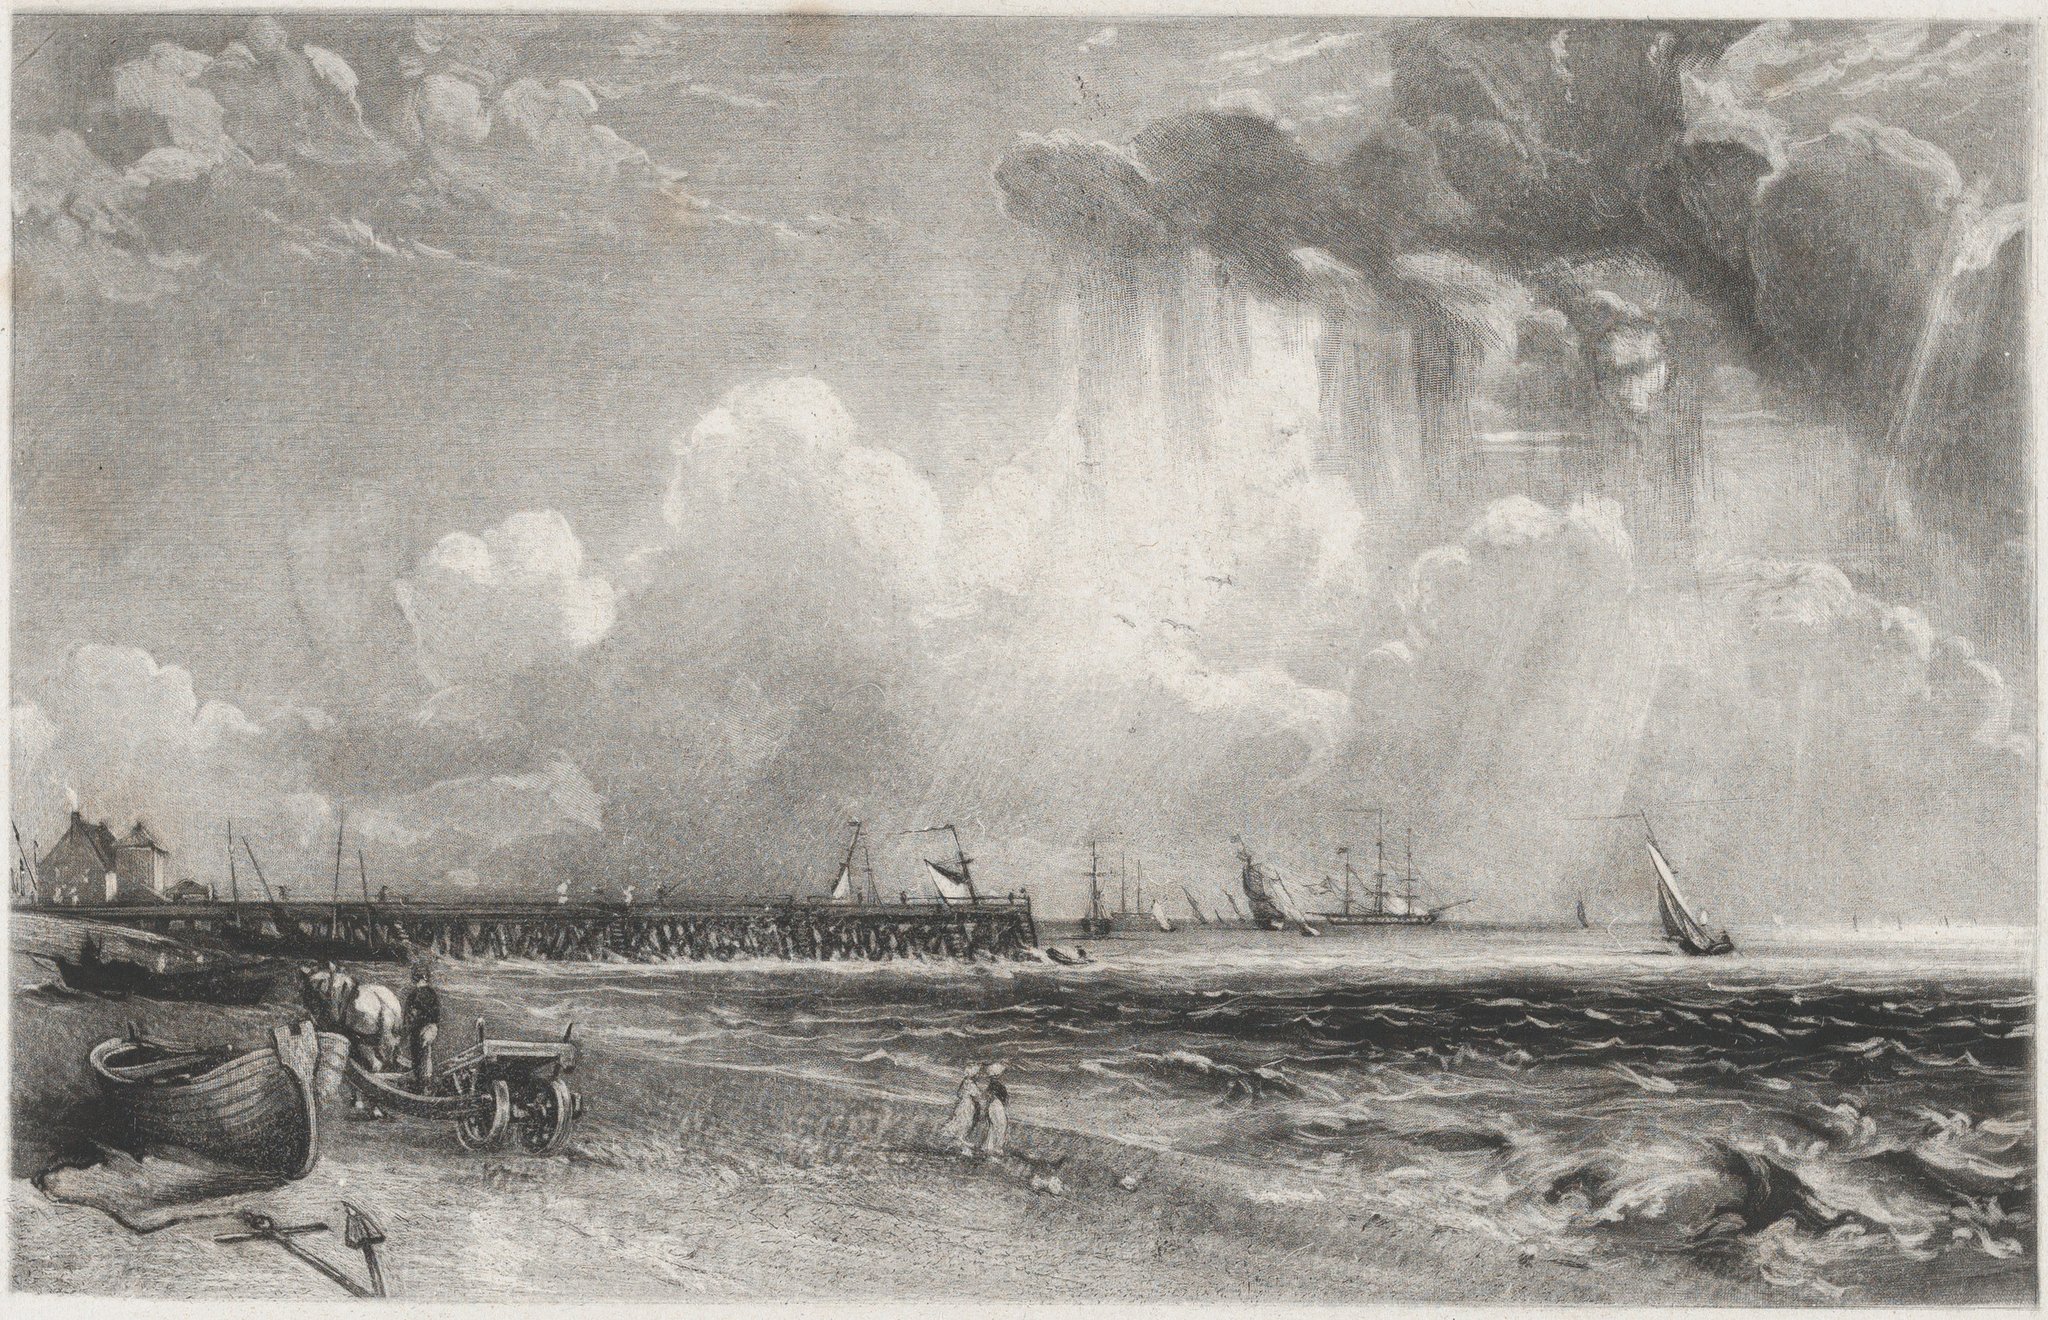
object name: print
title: Yarmouth, Norfolk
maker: david lucas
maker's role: artist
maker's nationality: british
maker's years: 1802-1881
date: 1830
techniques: mezzotint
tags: seascapes,boats,piers